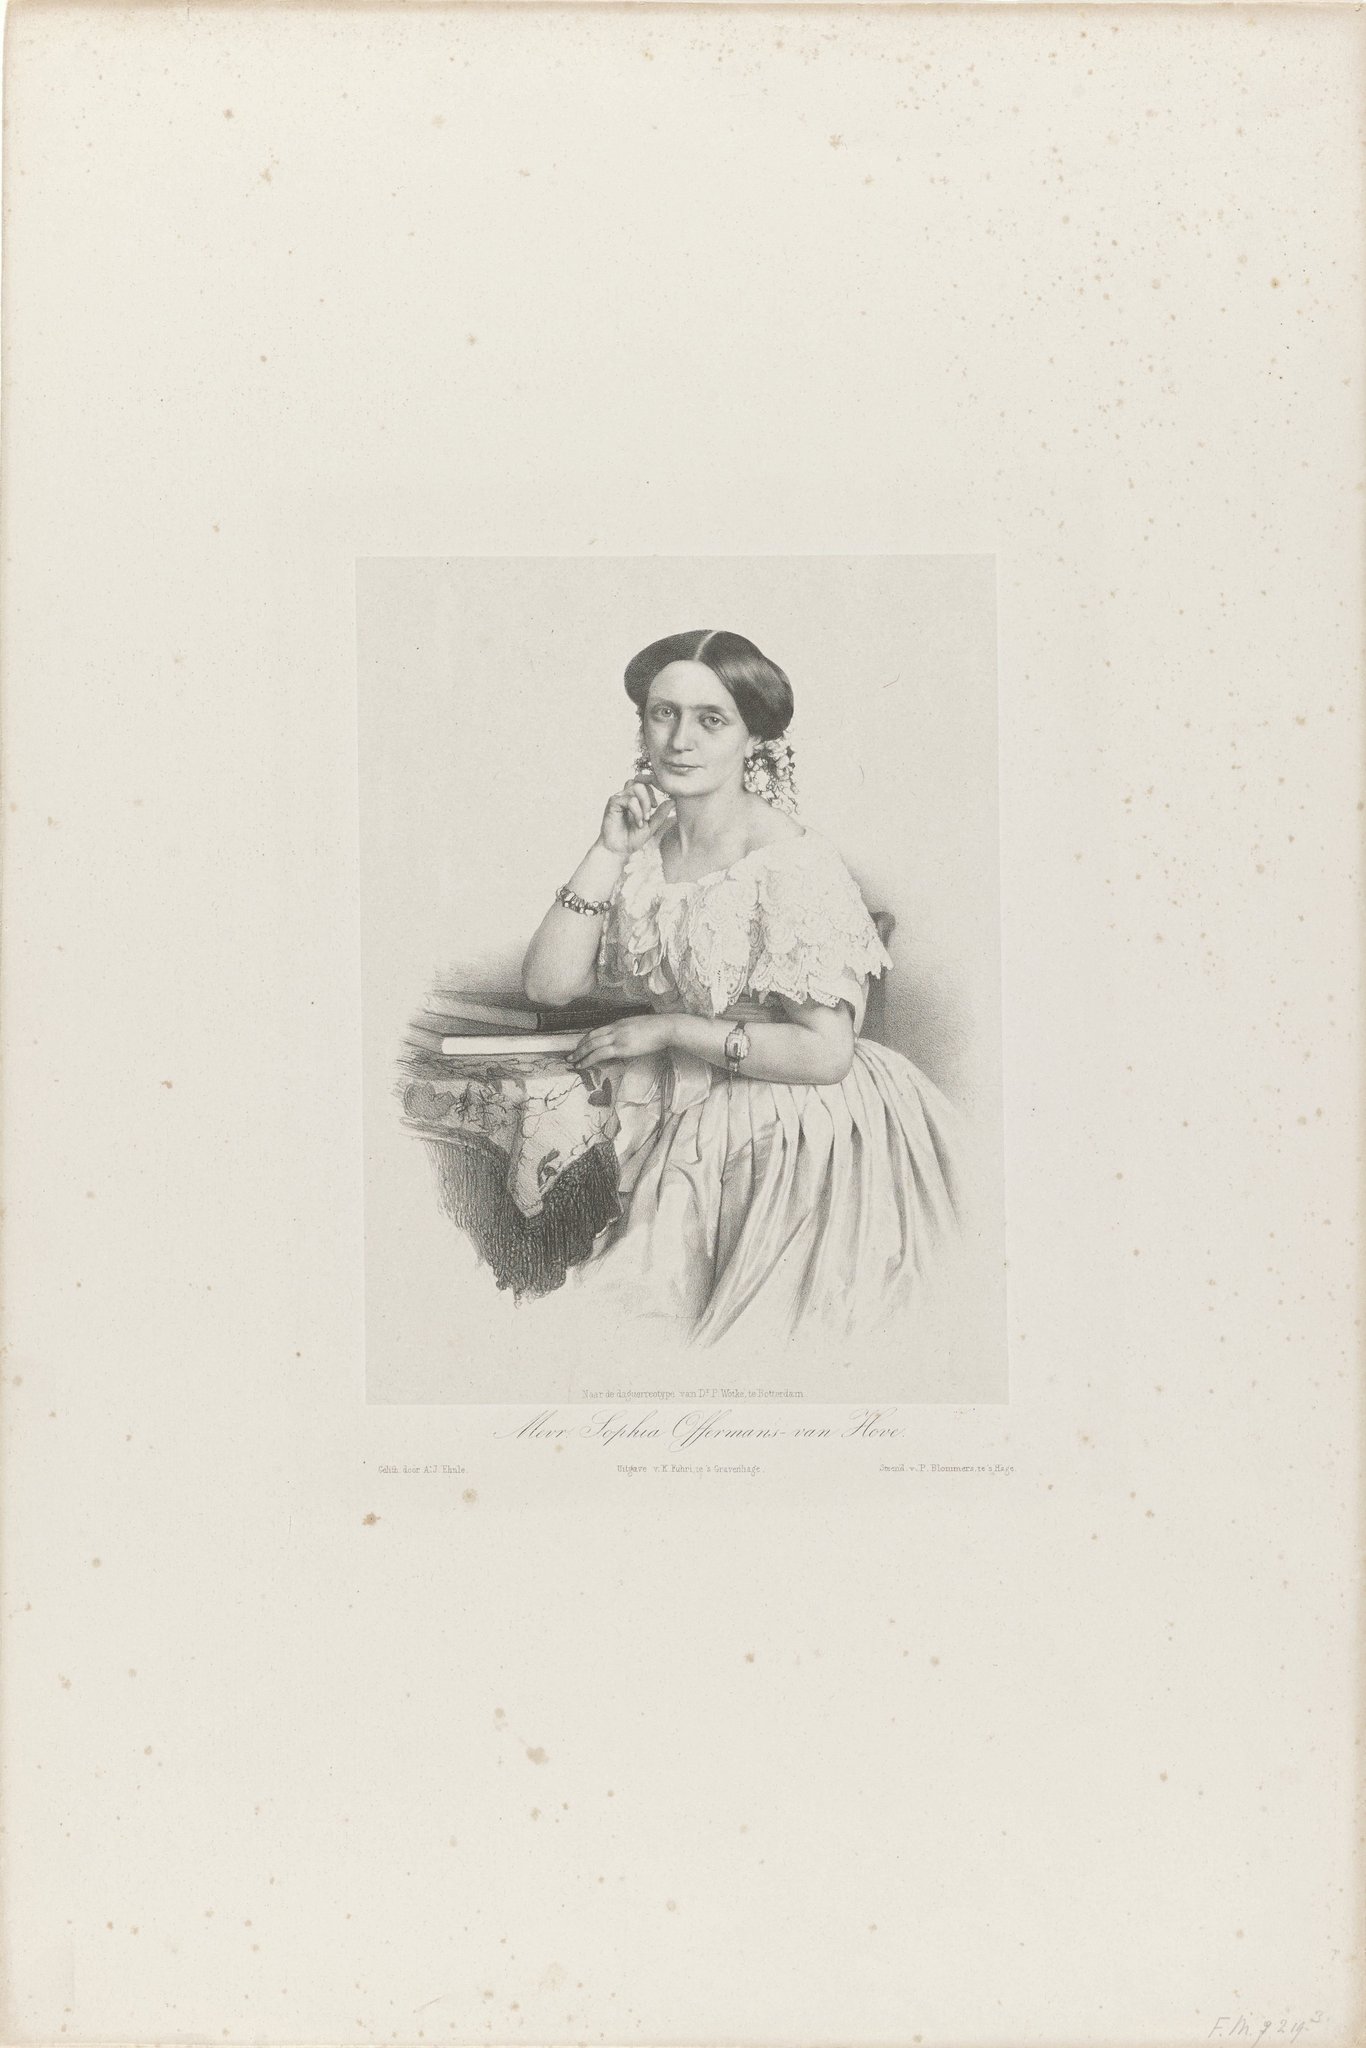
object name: print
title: De Maatschappij ter Bevordering van Toonkunst, haar Muziekfeest en de stad Rotterdam. herinnering aan het jaar 1854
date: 1855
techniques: printmaking, lithograph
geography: the hague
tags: rotterdam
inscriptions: collector's mark: Lugt 2228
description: Portret van de zangeres Sophie Offermans-van Hove , zittend aan een tafel, 1854. Onderdeel van een serie van twaalf portretten naar daguerrotypieën en twaalf stadsgezichten. Ter gelegenheid van het Muziekfeest ter viering van het 25-jarige bestaan van de Maatschappij ter Bevordering van Toonkunst in Rotterdam, 12-15 juli 1854.